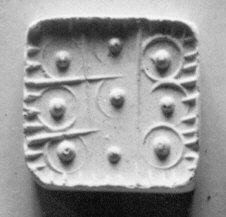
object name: stamp seal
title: Ridge-handled thin rectangular plaque seal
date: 5000-3001 BCE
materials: mineral, stone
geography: northern syria or northern mesopotamia